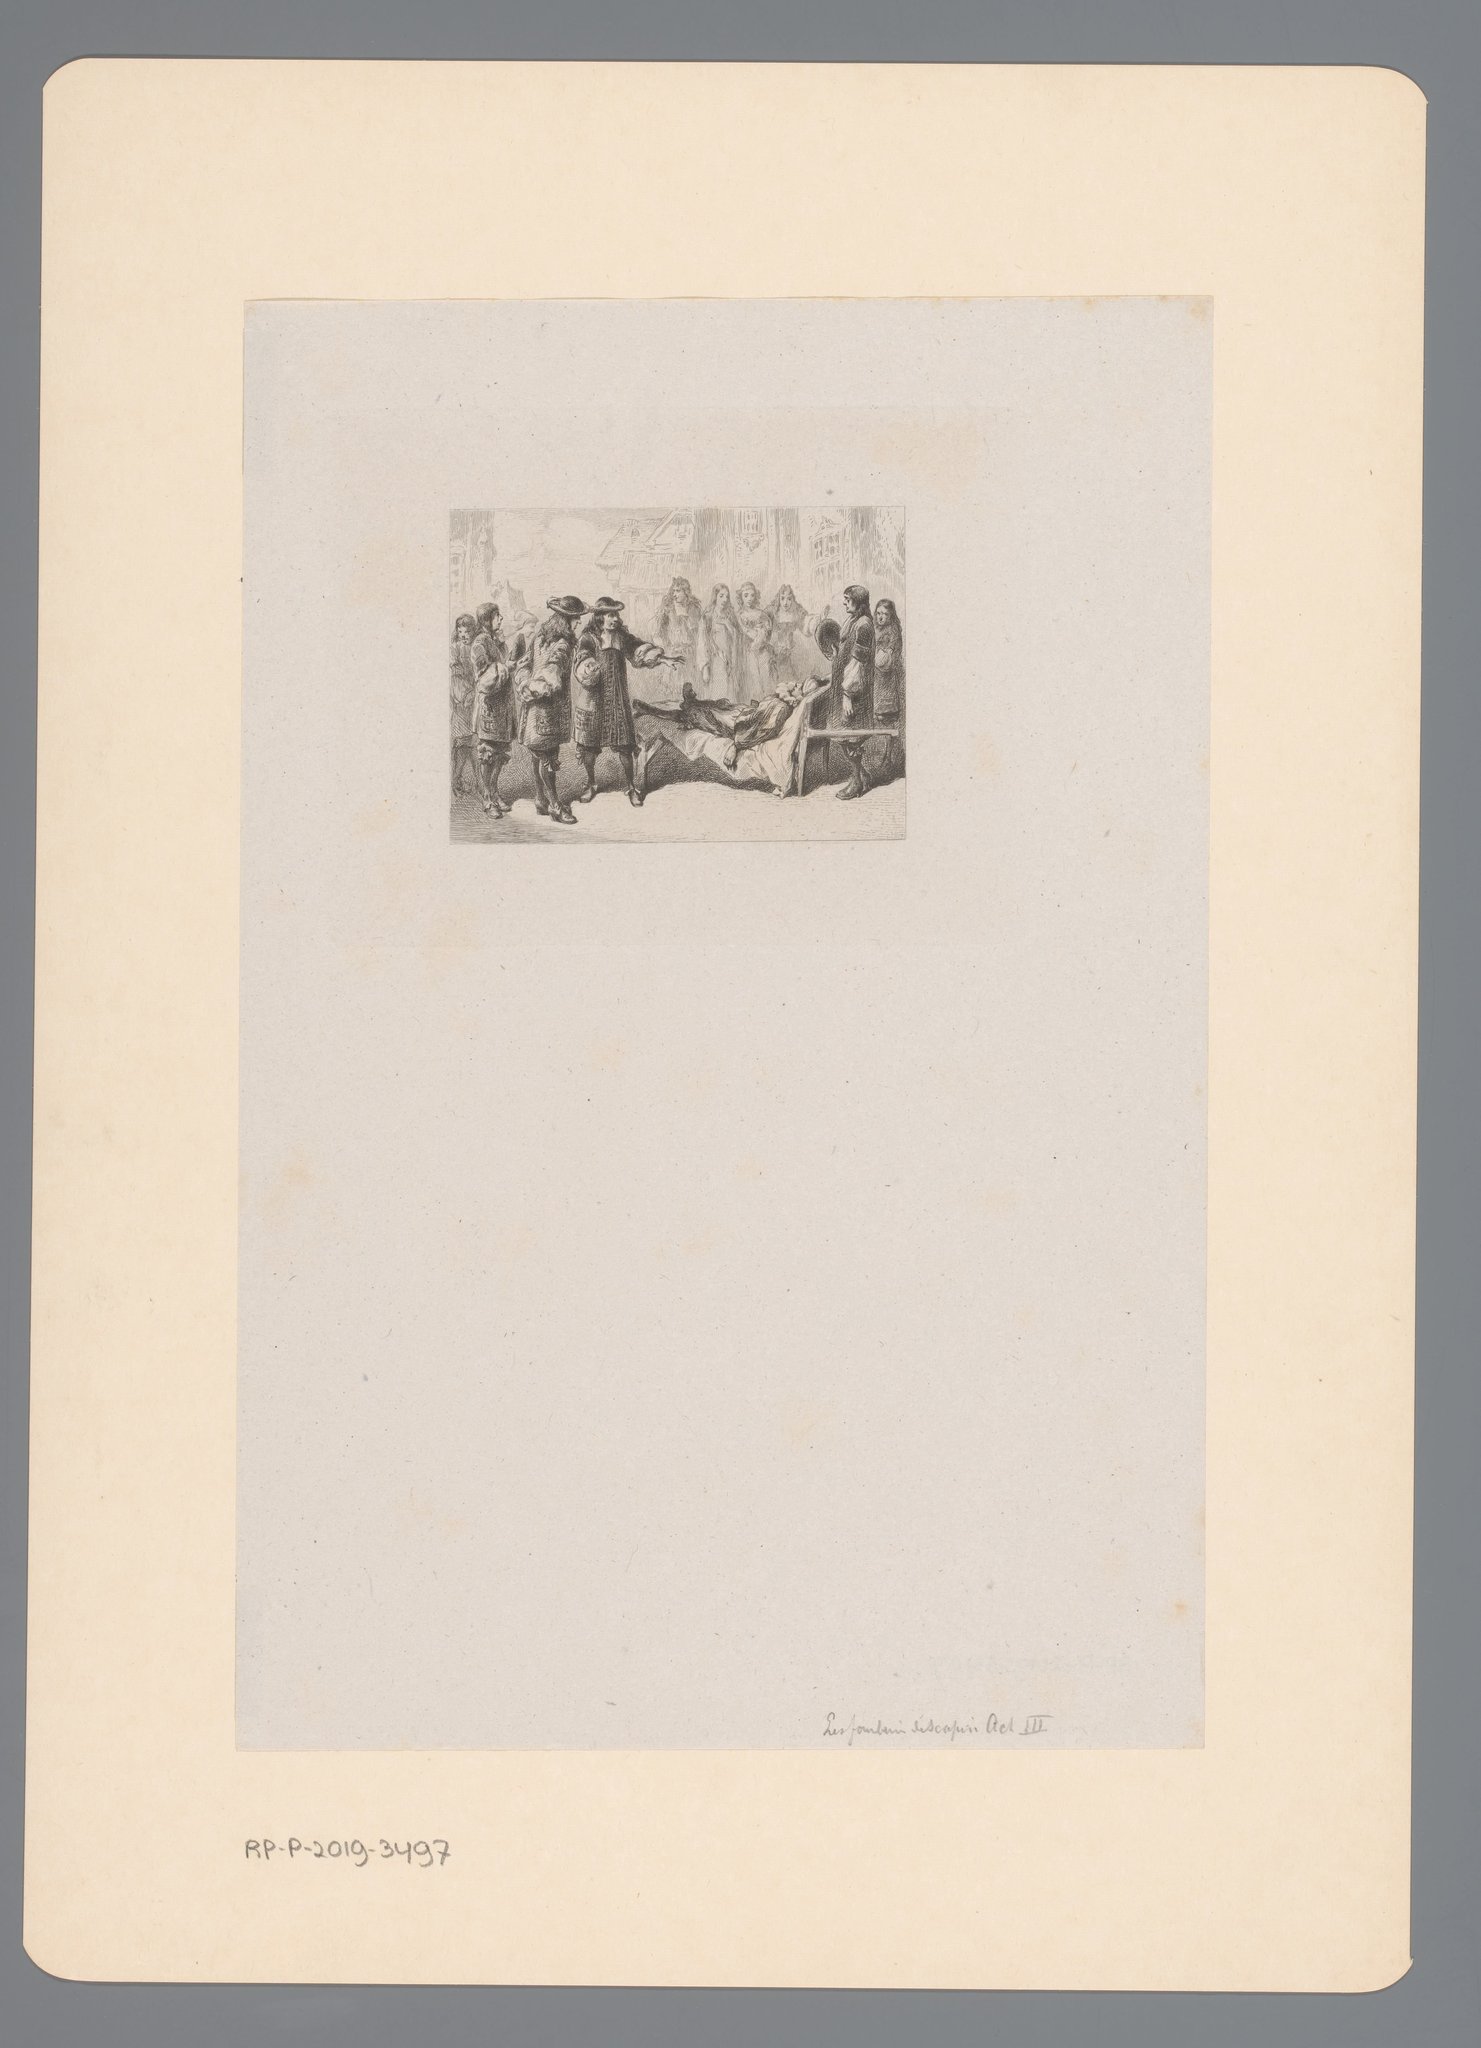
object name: print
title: Molière Théatre Choisi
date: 1878-1879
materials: paper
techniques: drypoint, etching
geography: tours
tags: (carrying a person on a) litter, stretcher, theatre, theatrical performance, person feigning illness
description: Akte III, scène XIII uit "Les Fourberies de Scapin" van Molière. Doordat Argante en Geronte denken dat Scapin stervende is, vergeven ze hem alles wat hij gedaan heeft.